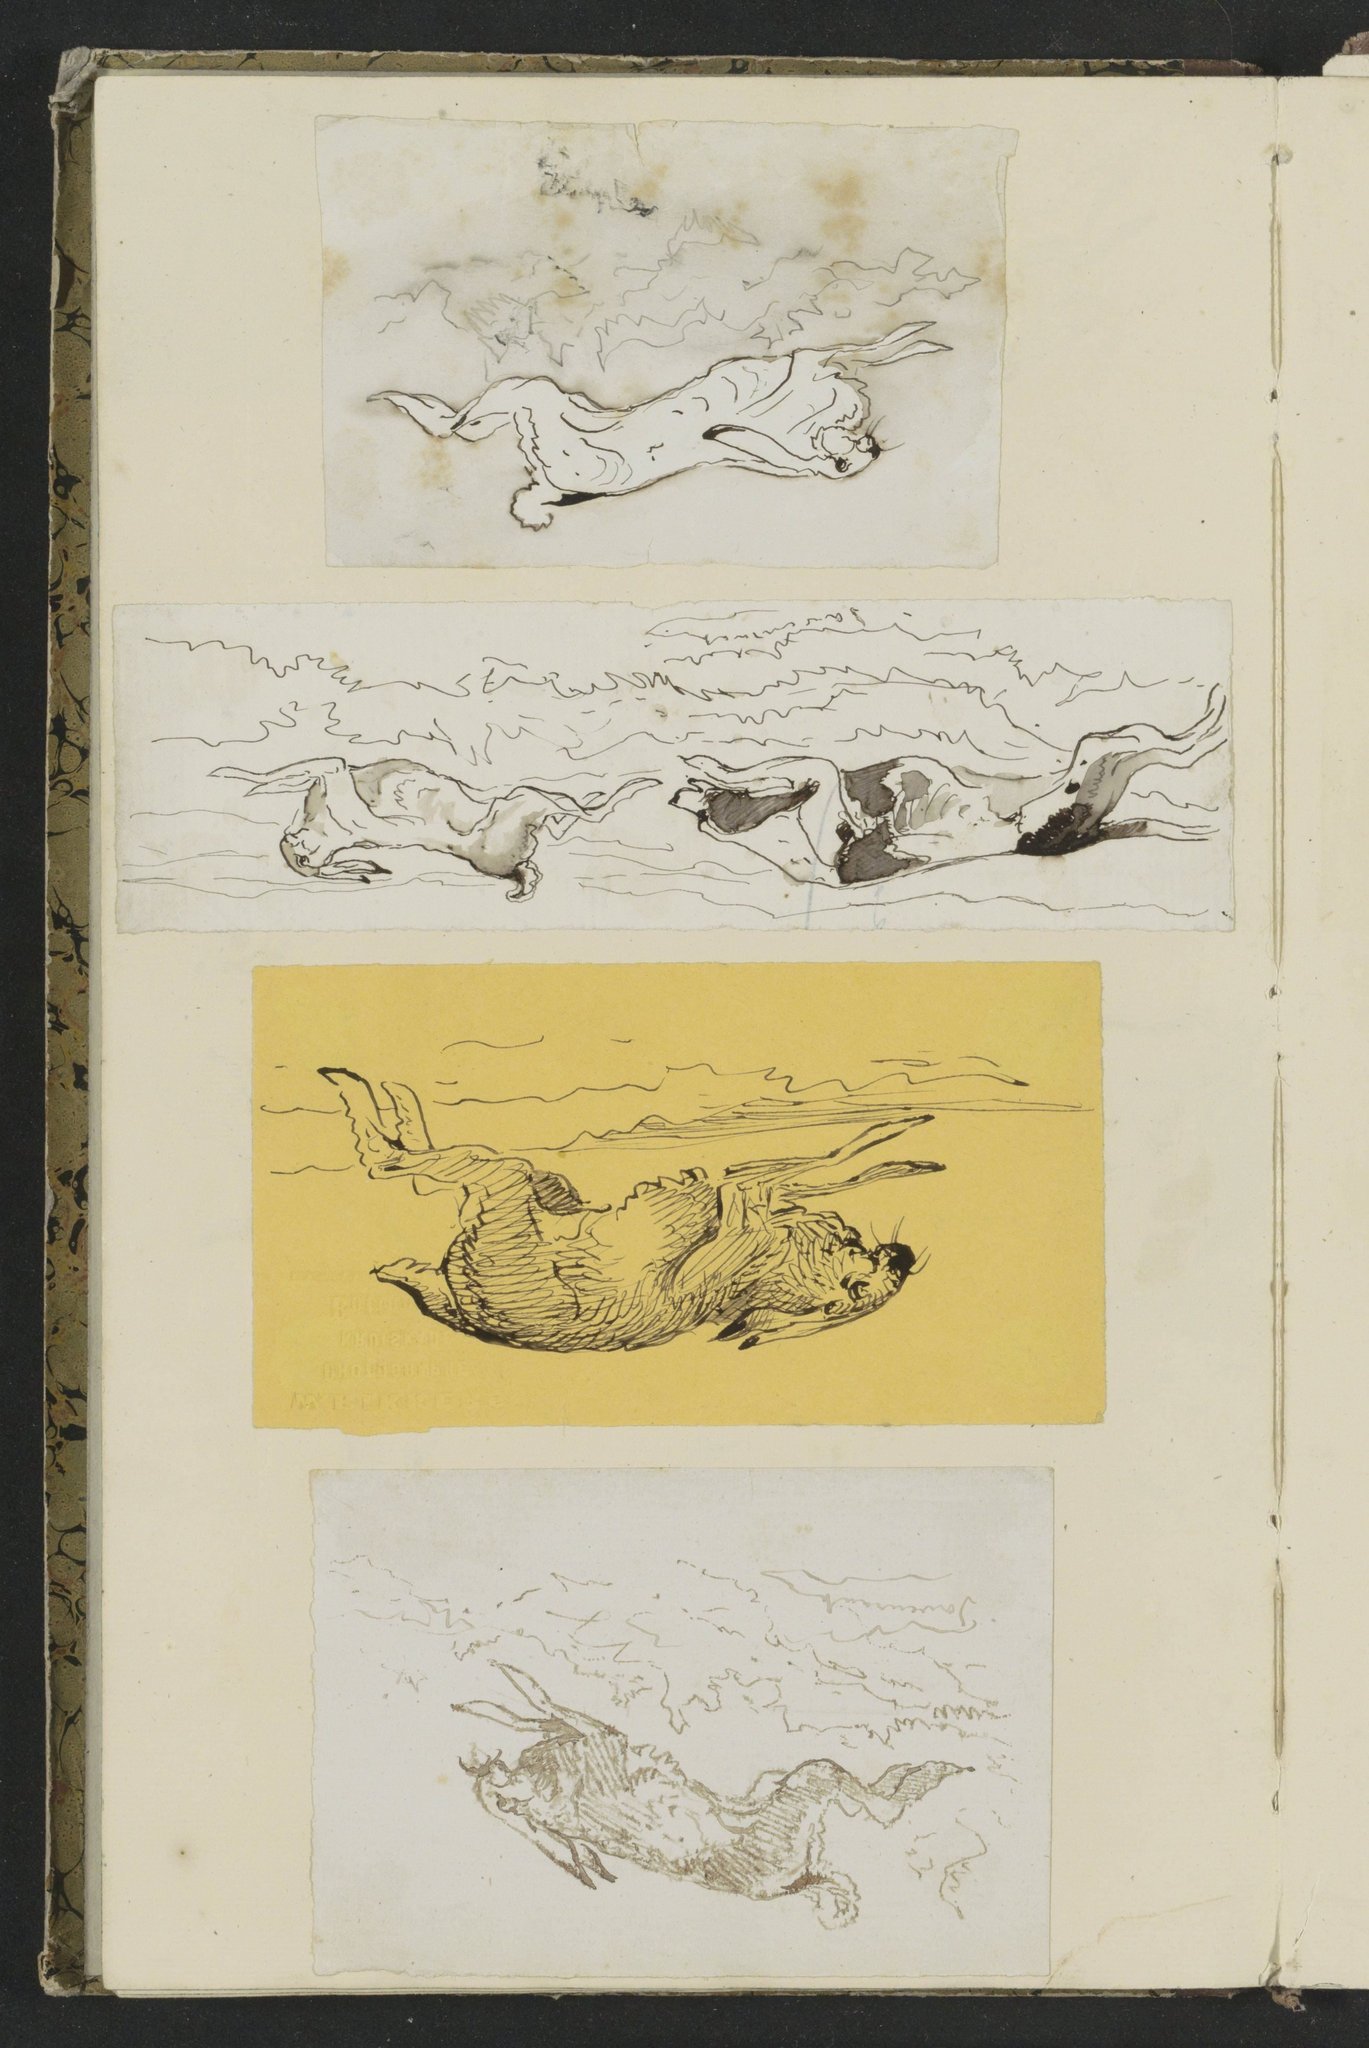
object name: sketchbook leaf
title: Hazen en een hond die een haas achterna zit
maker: johannes antonius canta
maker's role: draughtsman, painter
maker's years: 1816-1888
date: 1826-1888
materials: ink, paper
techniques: brush, pen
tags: rodents: hare, dog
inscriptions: signature: ‘Tavenraat’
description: Vermoedelijk stuurde Tavenraat deze studies naar Canta. Blad 54 verso uit een schetsboek en album met 59 bladen.